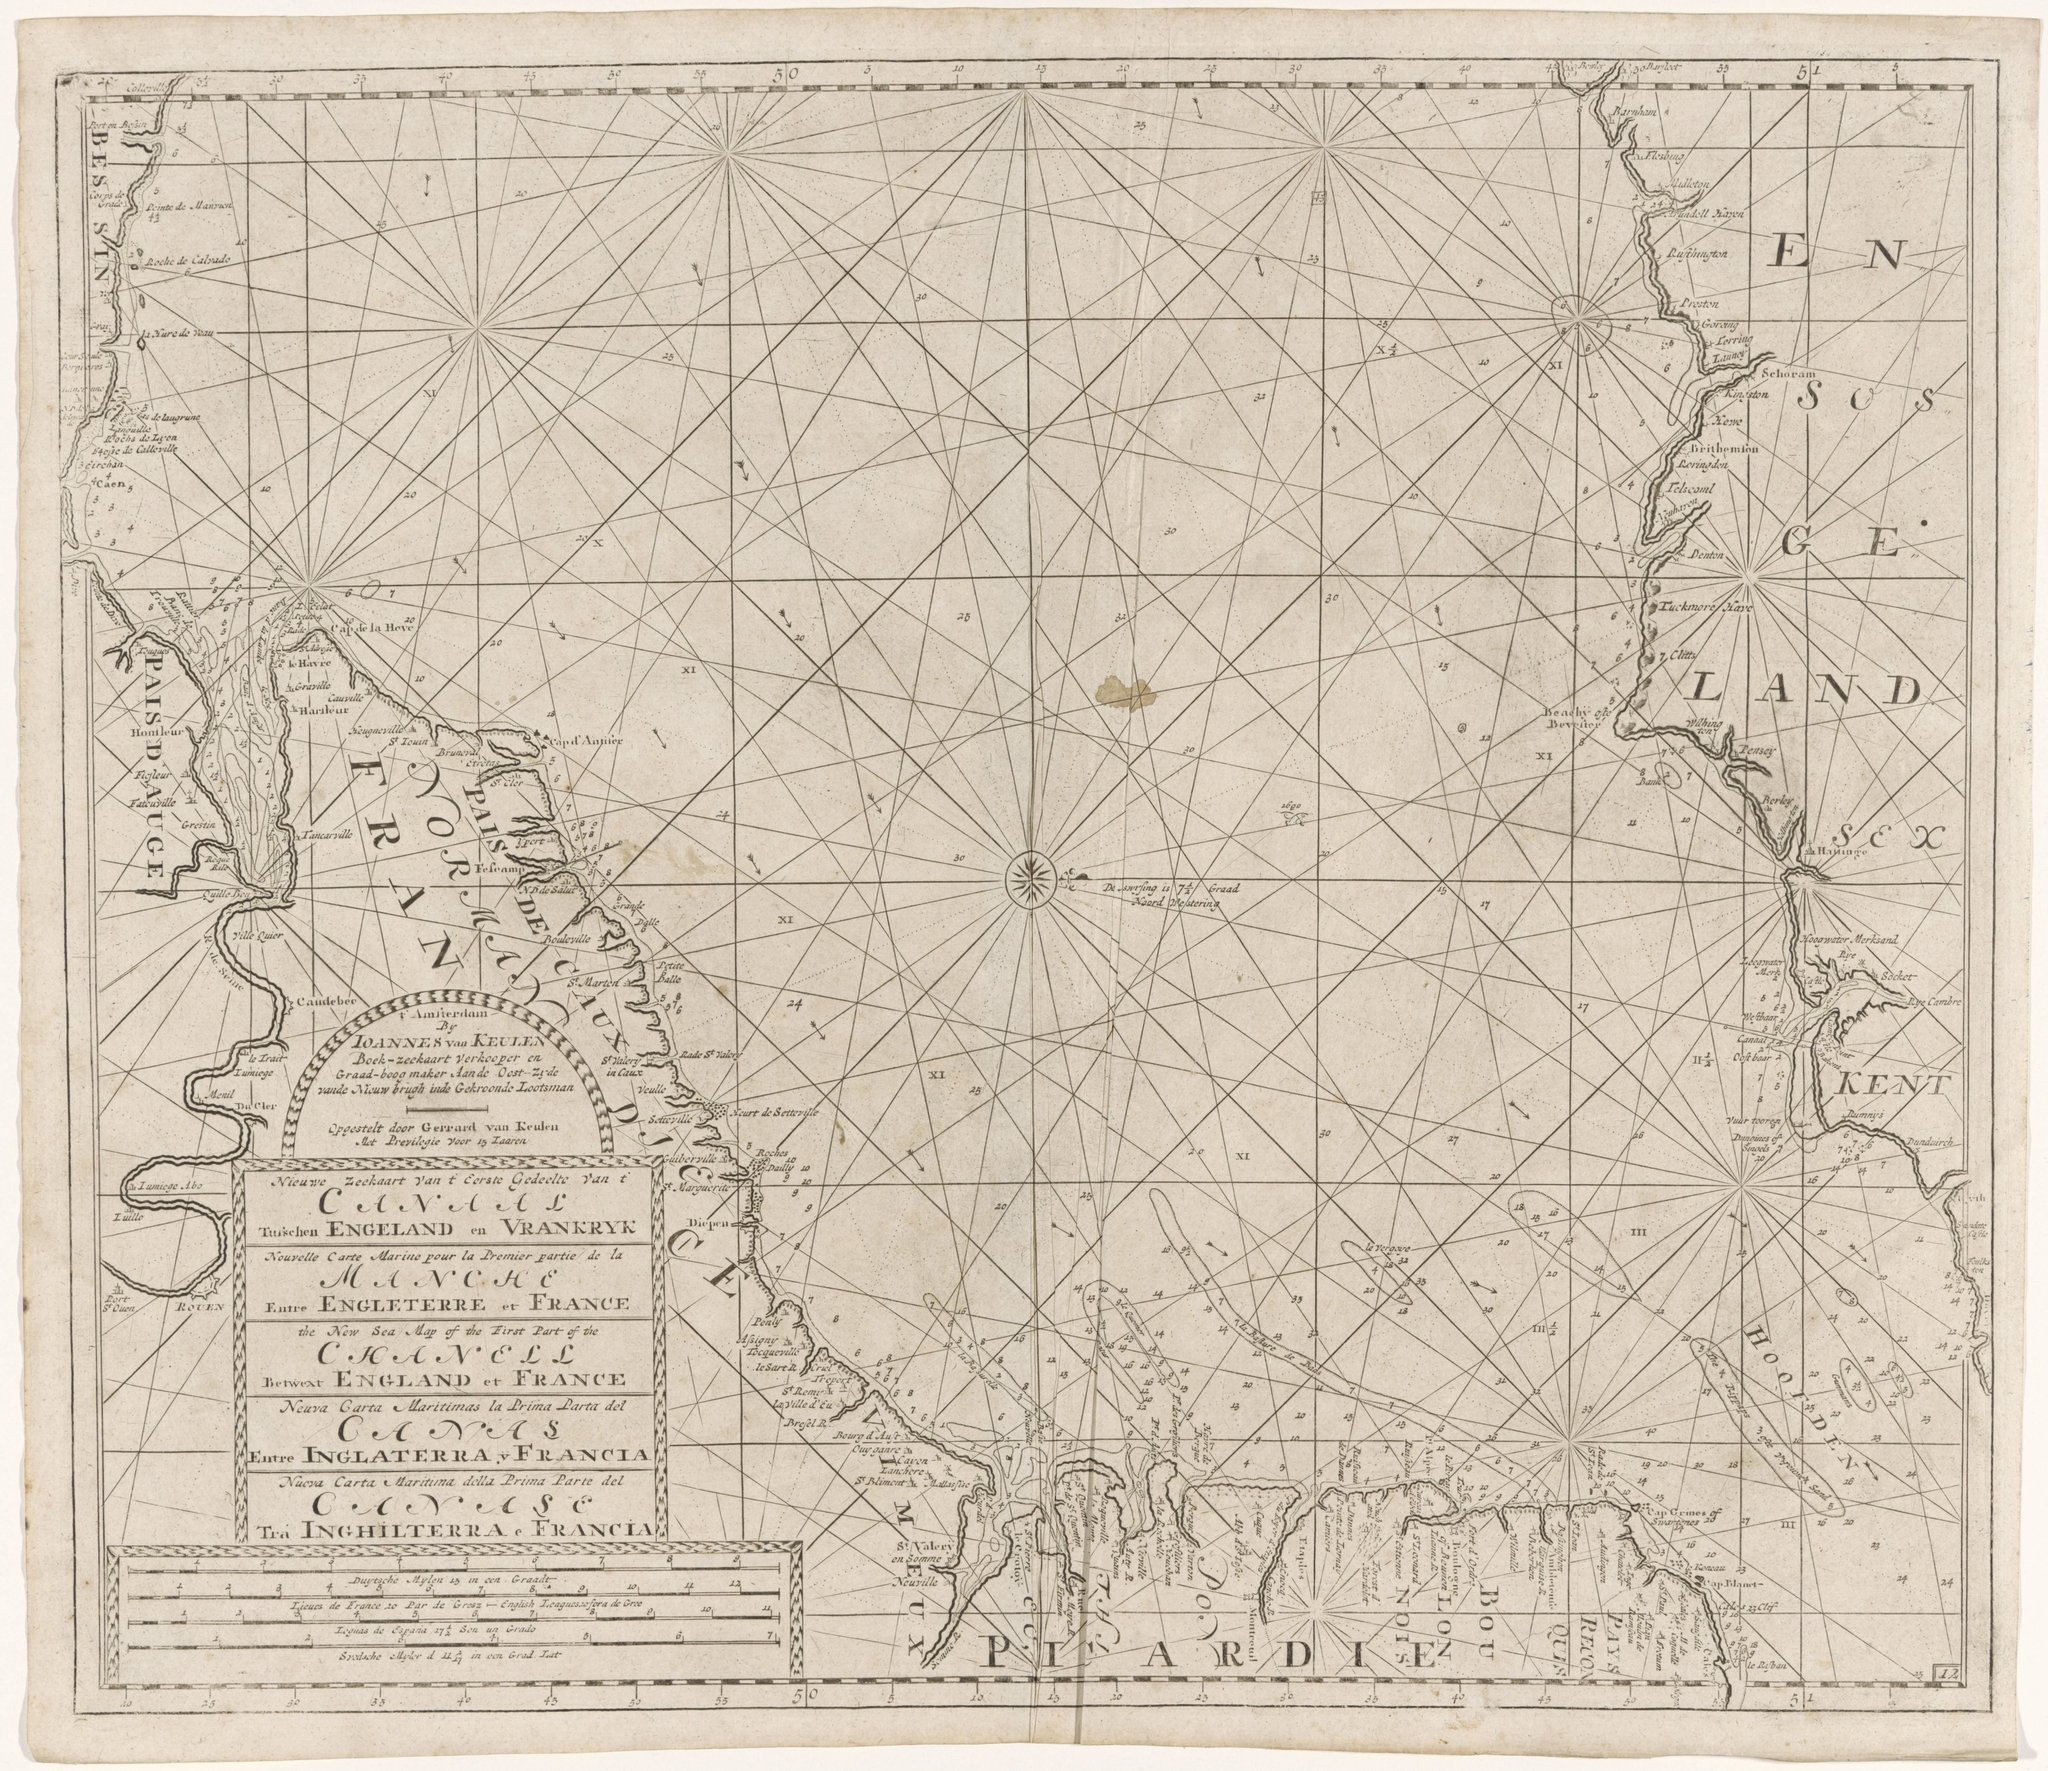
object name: print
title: Nieuwe Zeekaart van t' Eerste Gedeelte van t' Canaal Tuschen Engeland en Vrankryk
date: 1688-1803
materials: paper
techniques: engraving, etching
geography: amsterdam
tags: english channel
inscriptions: collector's mark: Lugt 2228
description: Paskaart van een gedeelte van Het Kanaal, de zeestraat tussen Groot-Brittannië en Frankrijk, met een kompasroos. Linksonder een cartouche met de titel, het adres van de uitgever en de schaalverdeling.